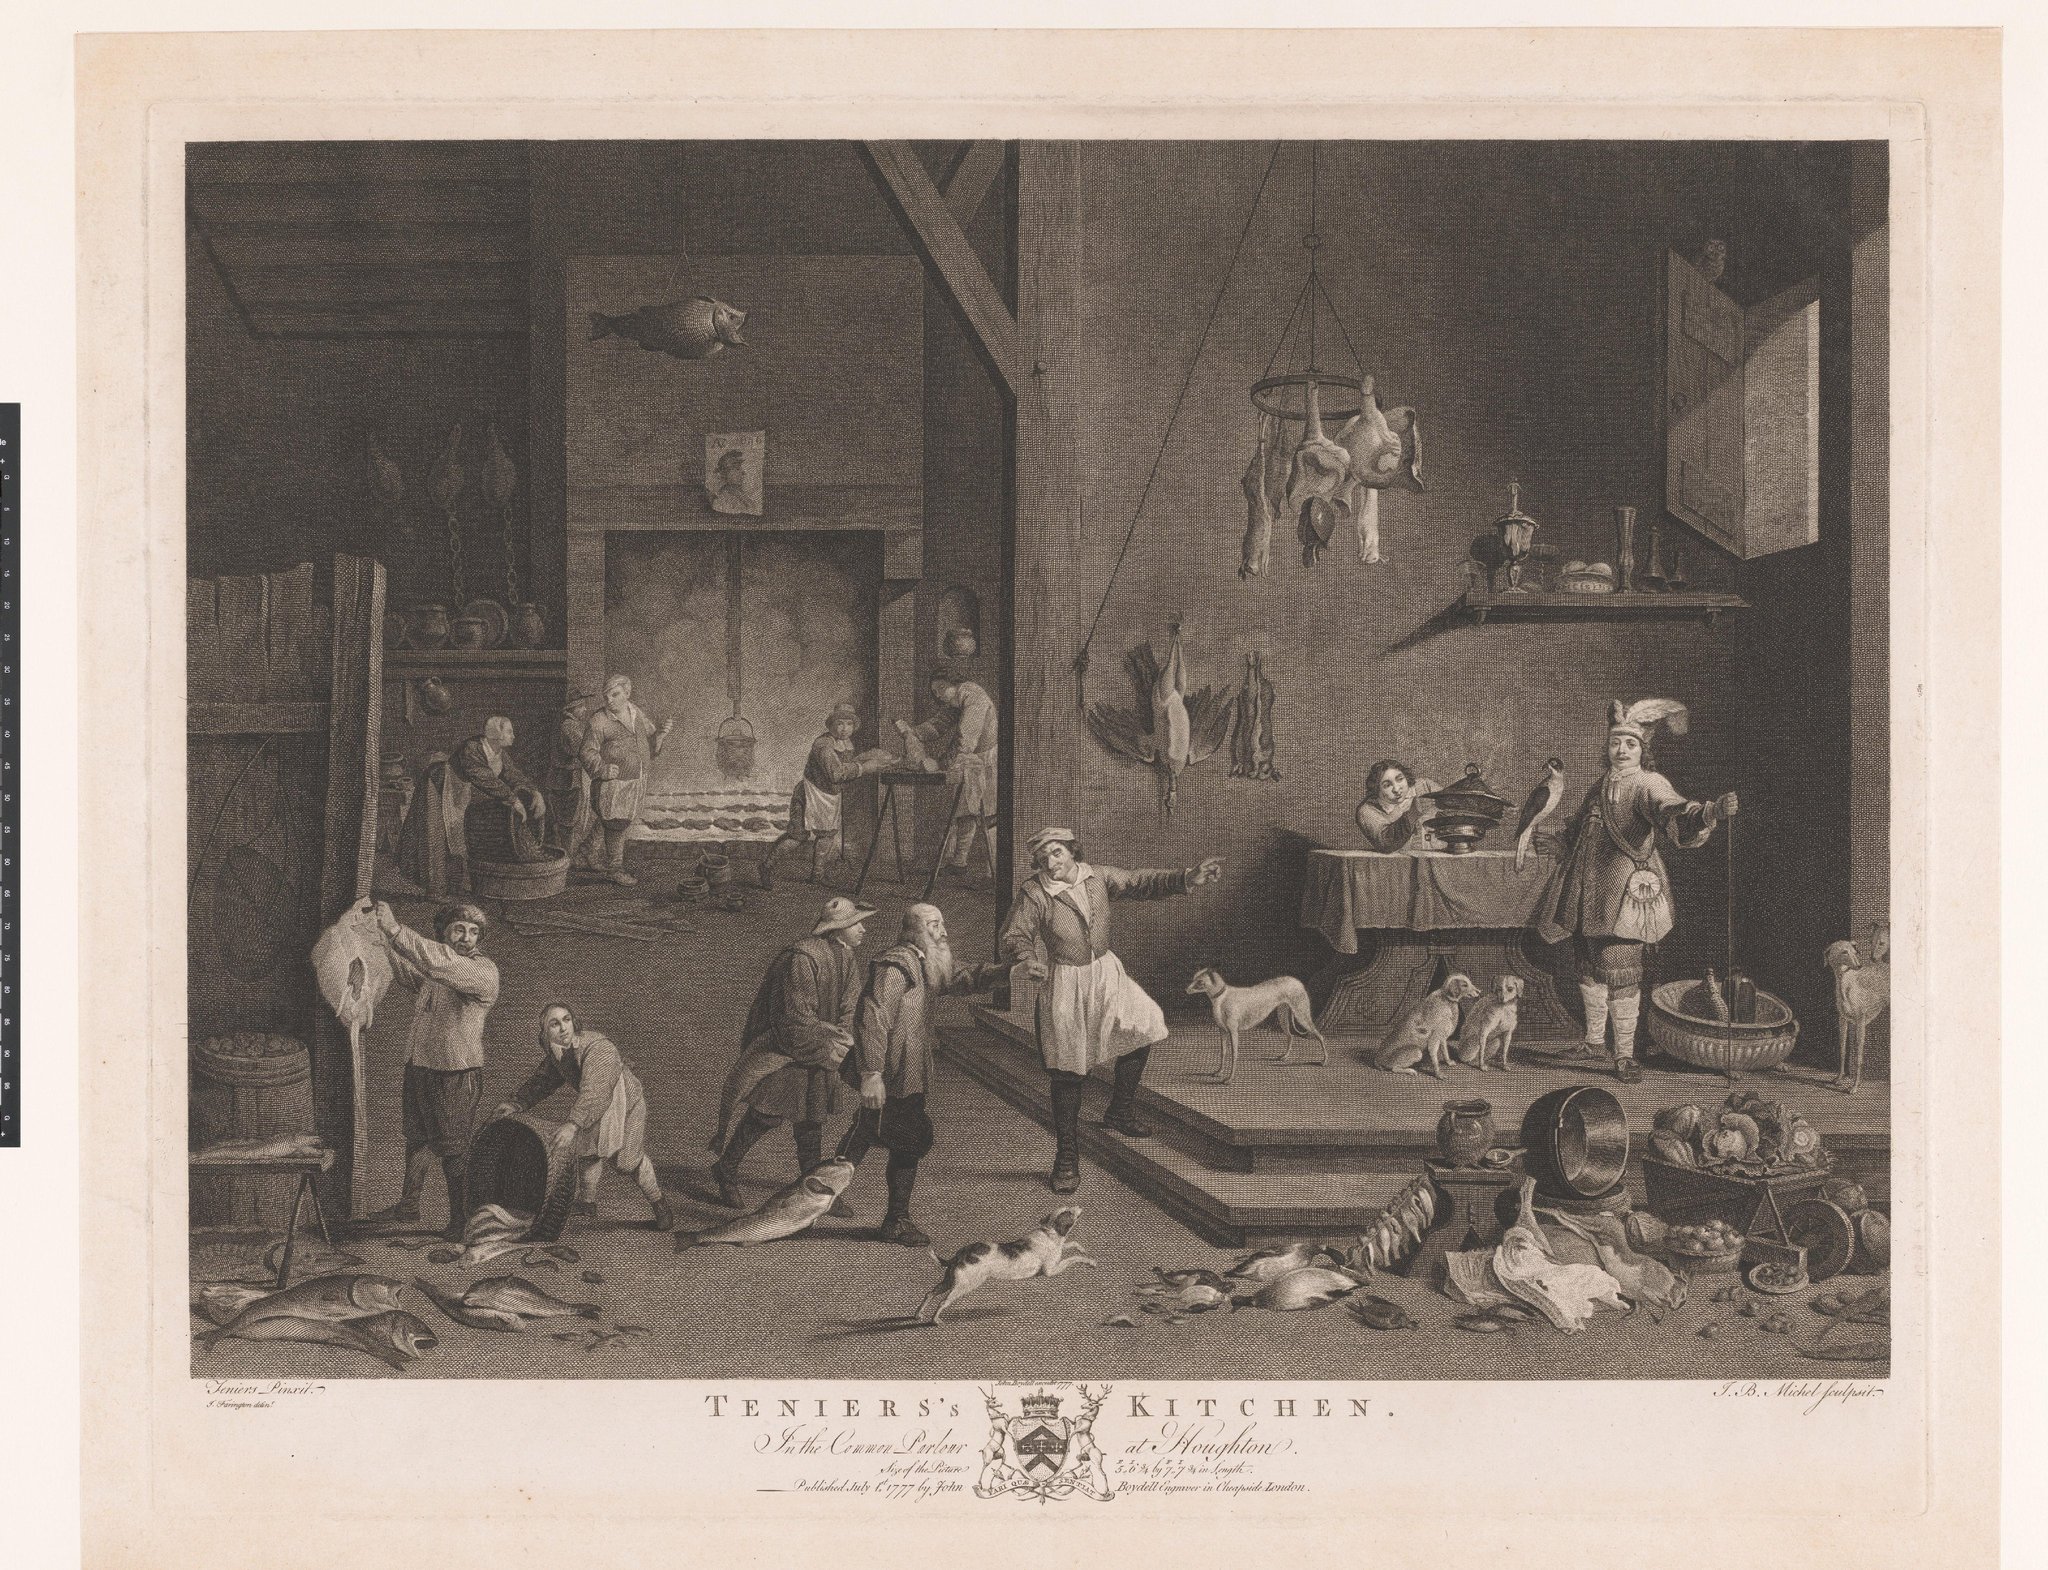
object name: print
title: Schilderijen uit The Houghton Gallery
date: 1777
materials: paper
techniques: engraving, etching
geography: london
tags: kitchen, armorial bearing, heraldry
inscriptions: watermark, collector's mark: Lugt 12